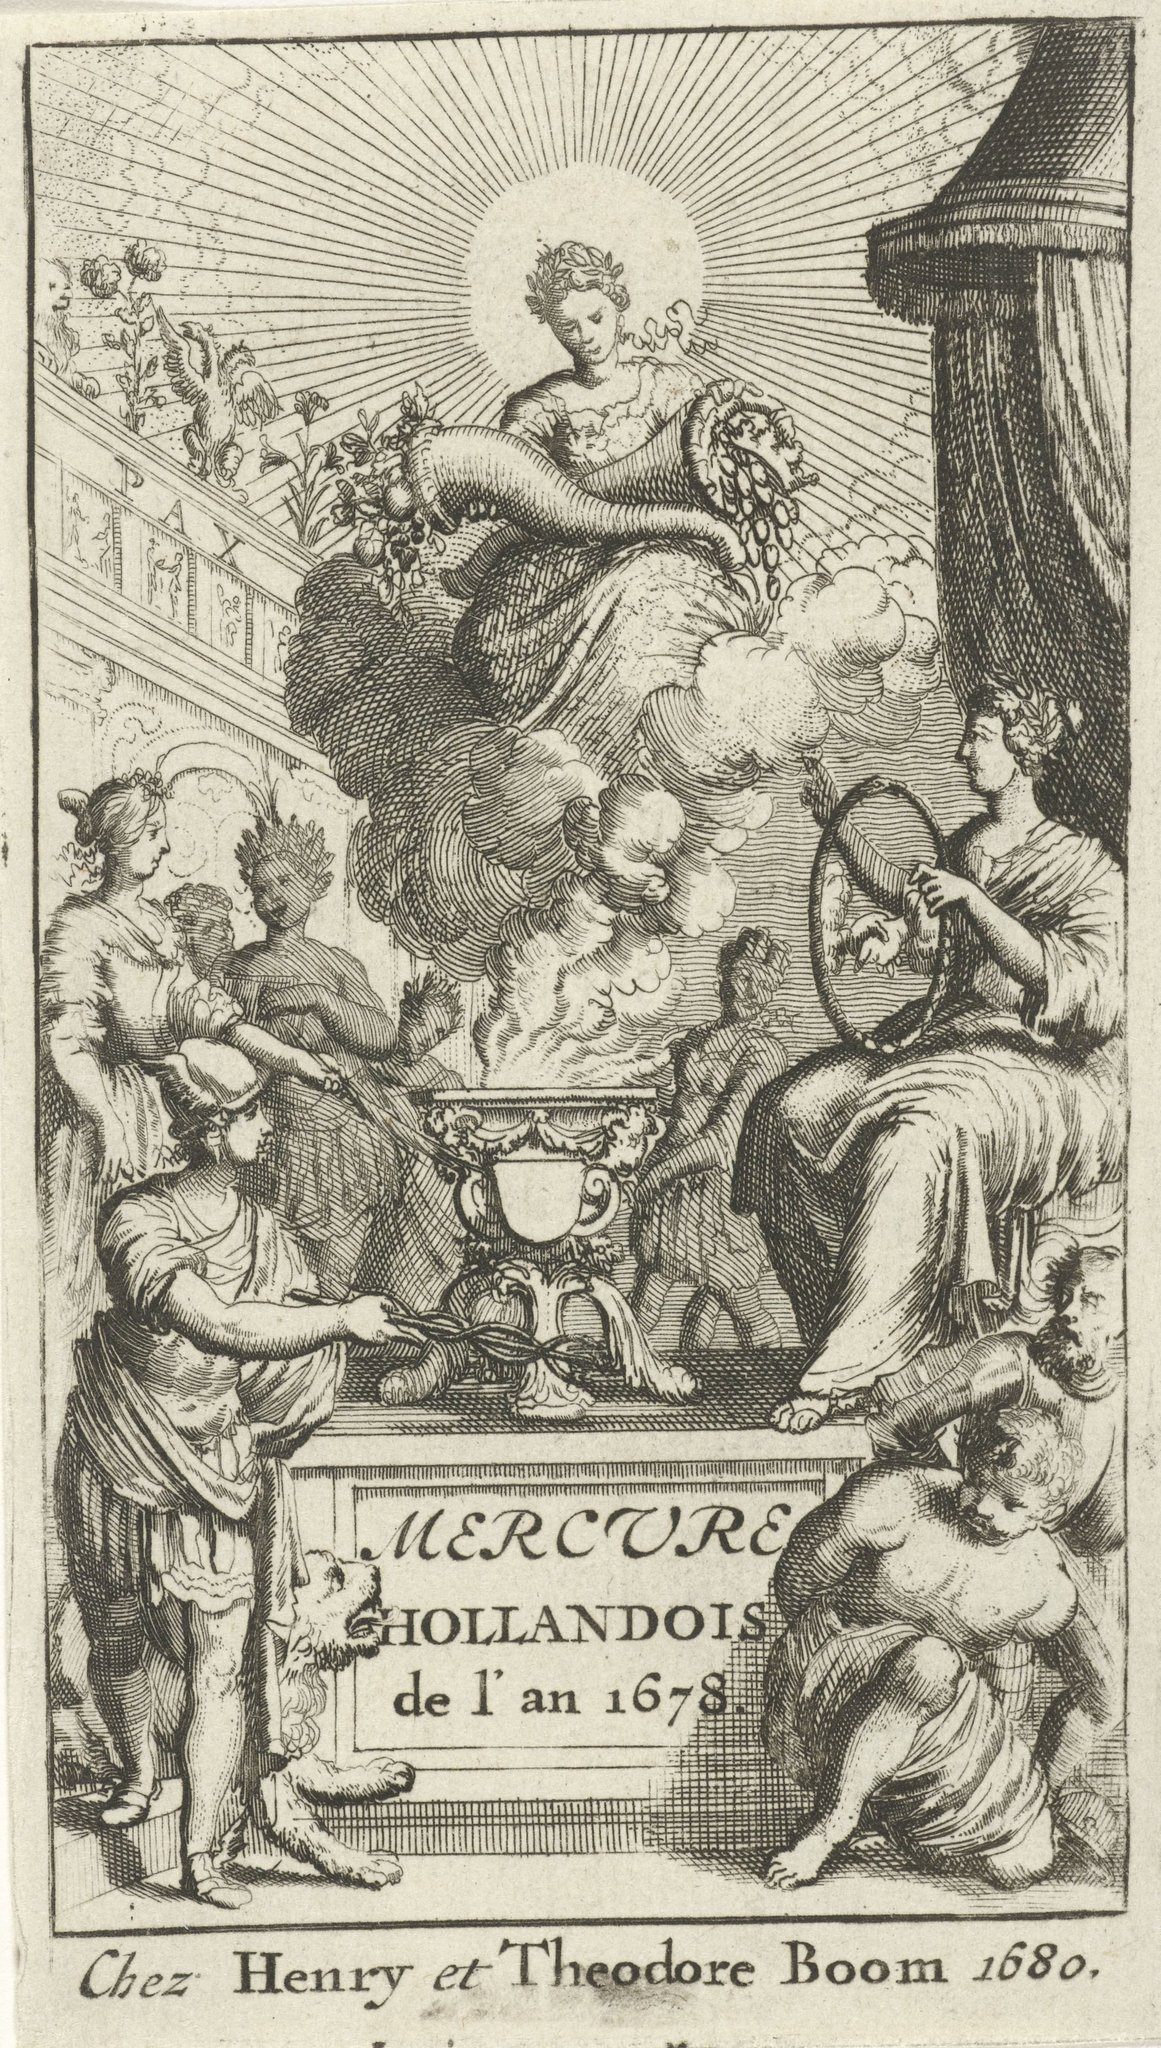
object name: print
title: Titelpagina voor: Le Mercure hollandois, dl VII, 1680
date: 1678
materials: paper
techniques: etching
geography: amsterdam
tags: (story of) mercury (hermes), abundance; 'abondanza', 'abondanza maritima' (ripa), serpent ouroboros, temple, shrine ~ non-christian religions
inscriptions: collector's mark: Lugt 2228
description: De gepersonifieerde overvloed verschijnt in de rook, afkomstig van een offerschaal. Rechts zit een vrouwenfiguur onder een baldakijn met het eeuwigheidssymbool (een slang die zich in eigen staart bijt) in haar handen, links staat Mercurius.